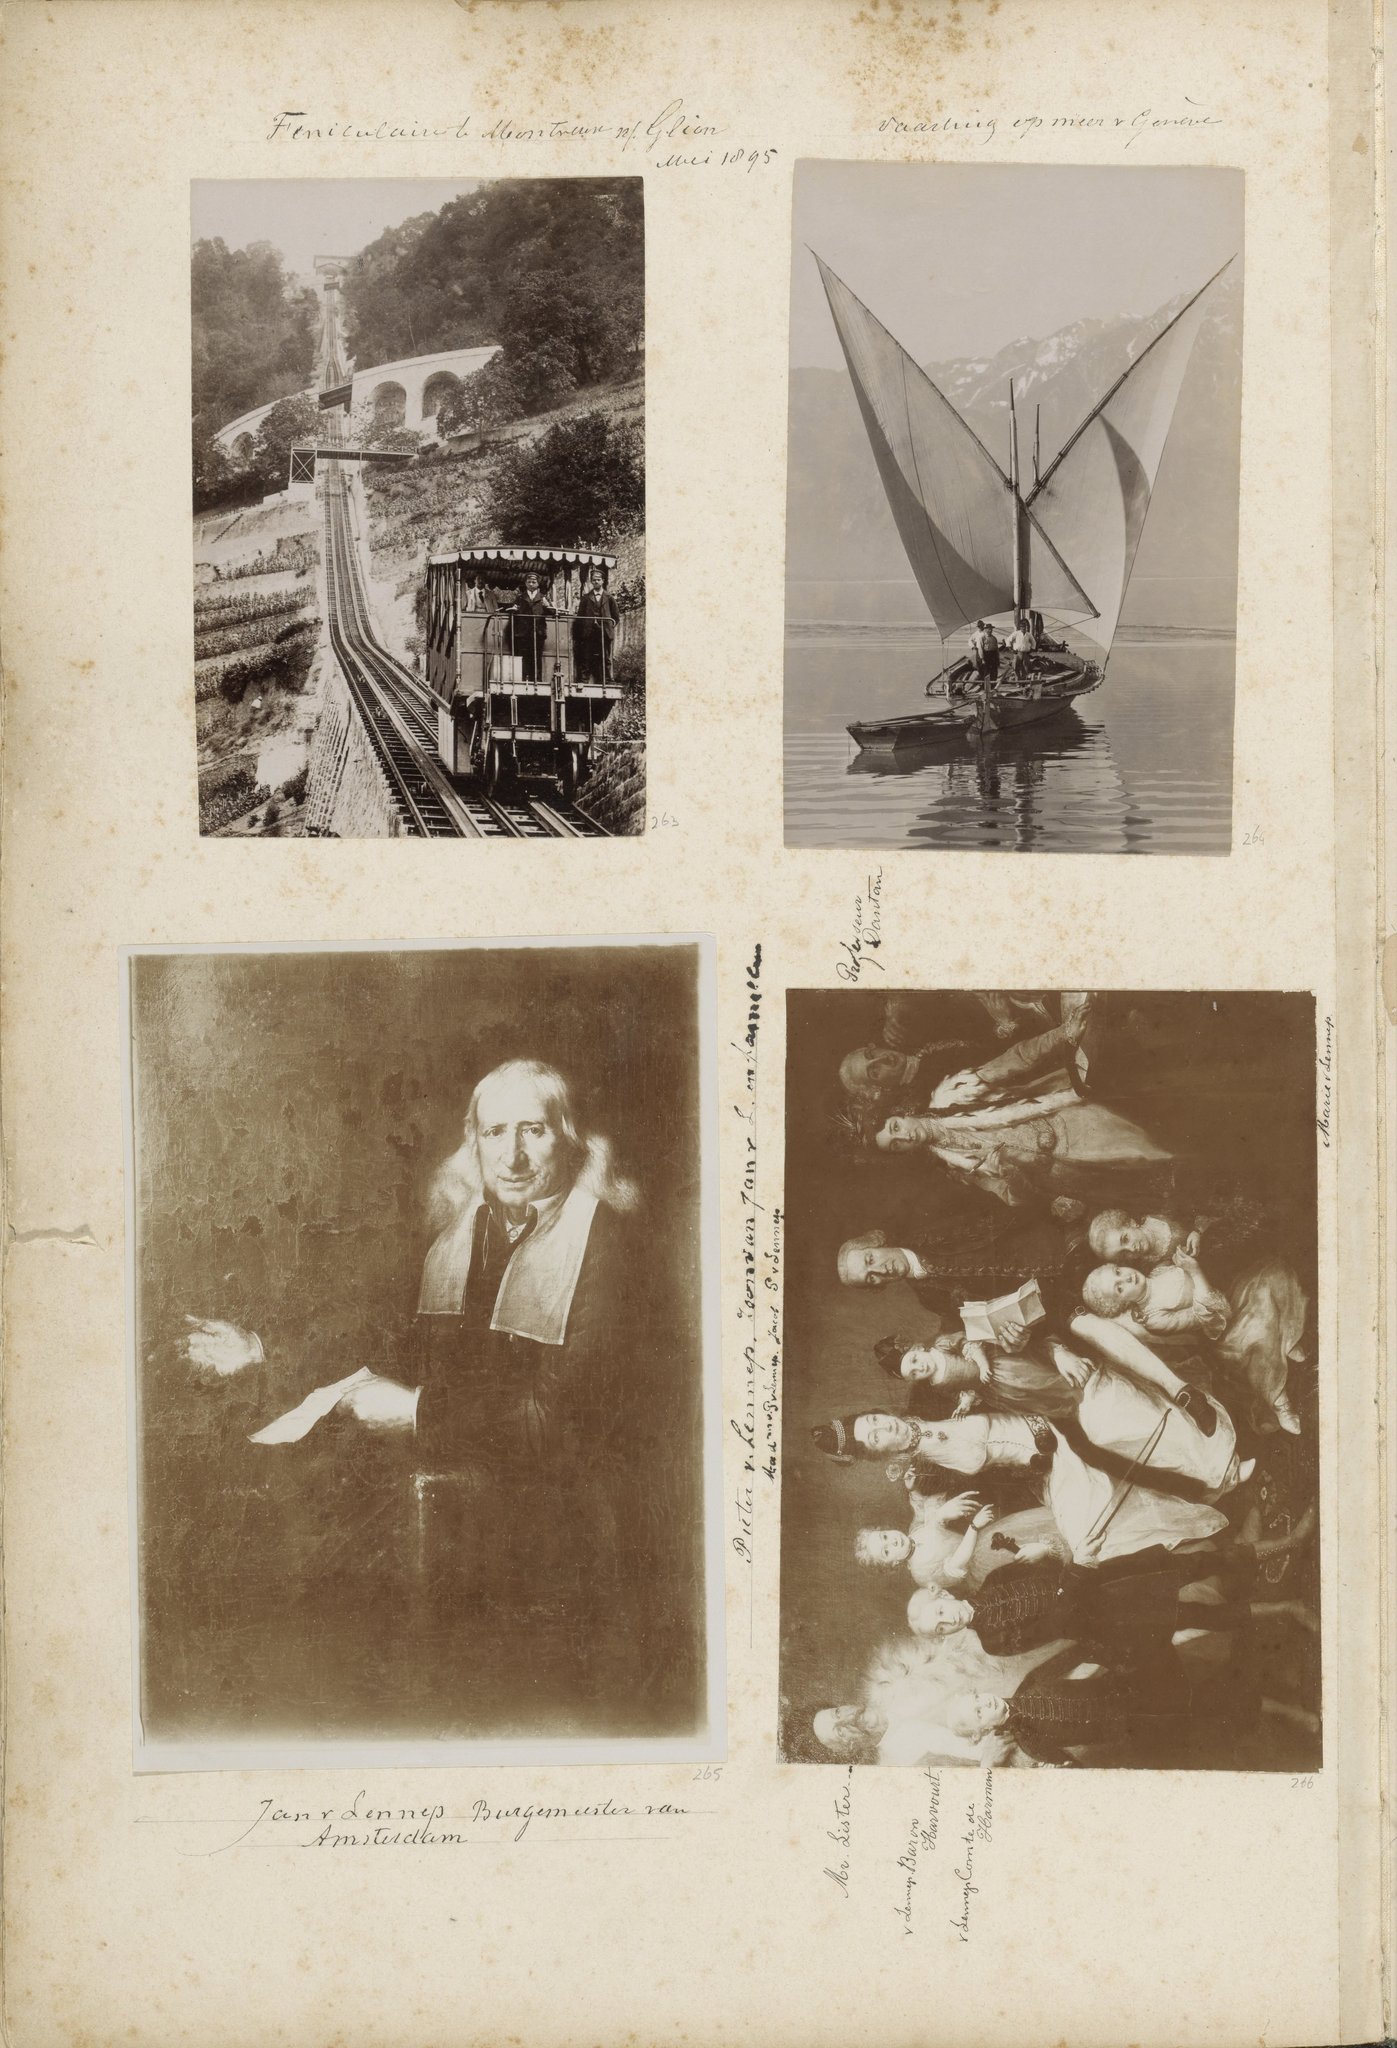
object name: photograph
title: Fotoreproductie van (vermoedelijk) een schilderij, voorstellend de Amsterdamse koopman en kunstverzamelaar Jan van Lennep de Oude (1634-1711)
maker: Anonymous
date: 1890-1910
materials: paper, photographic support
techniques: collodion silver print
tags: art collector, merchant, salesman, amsterdam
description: De Onderdeel van Fotoalbum van Robert Daniel Crommelin (1841-1907).